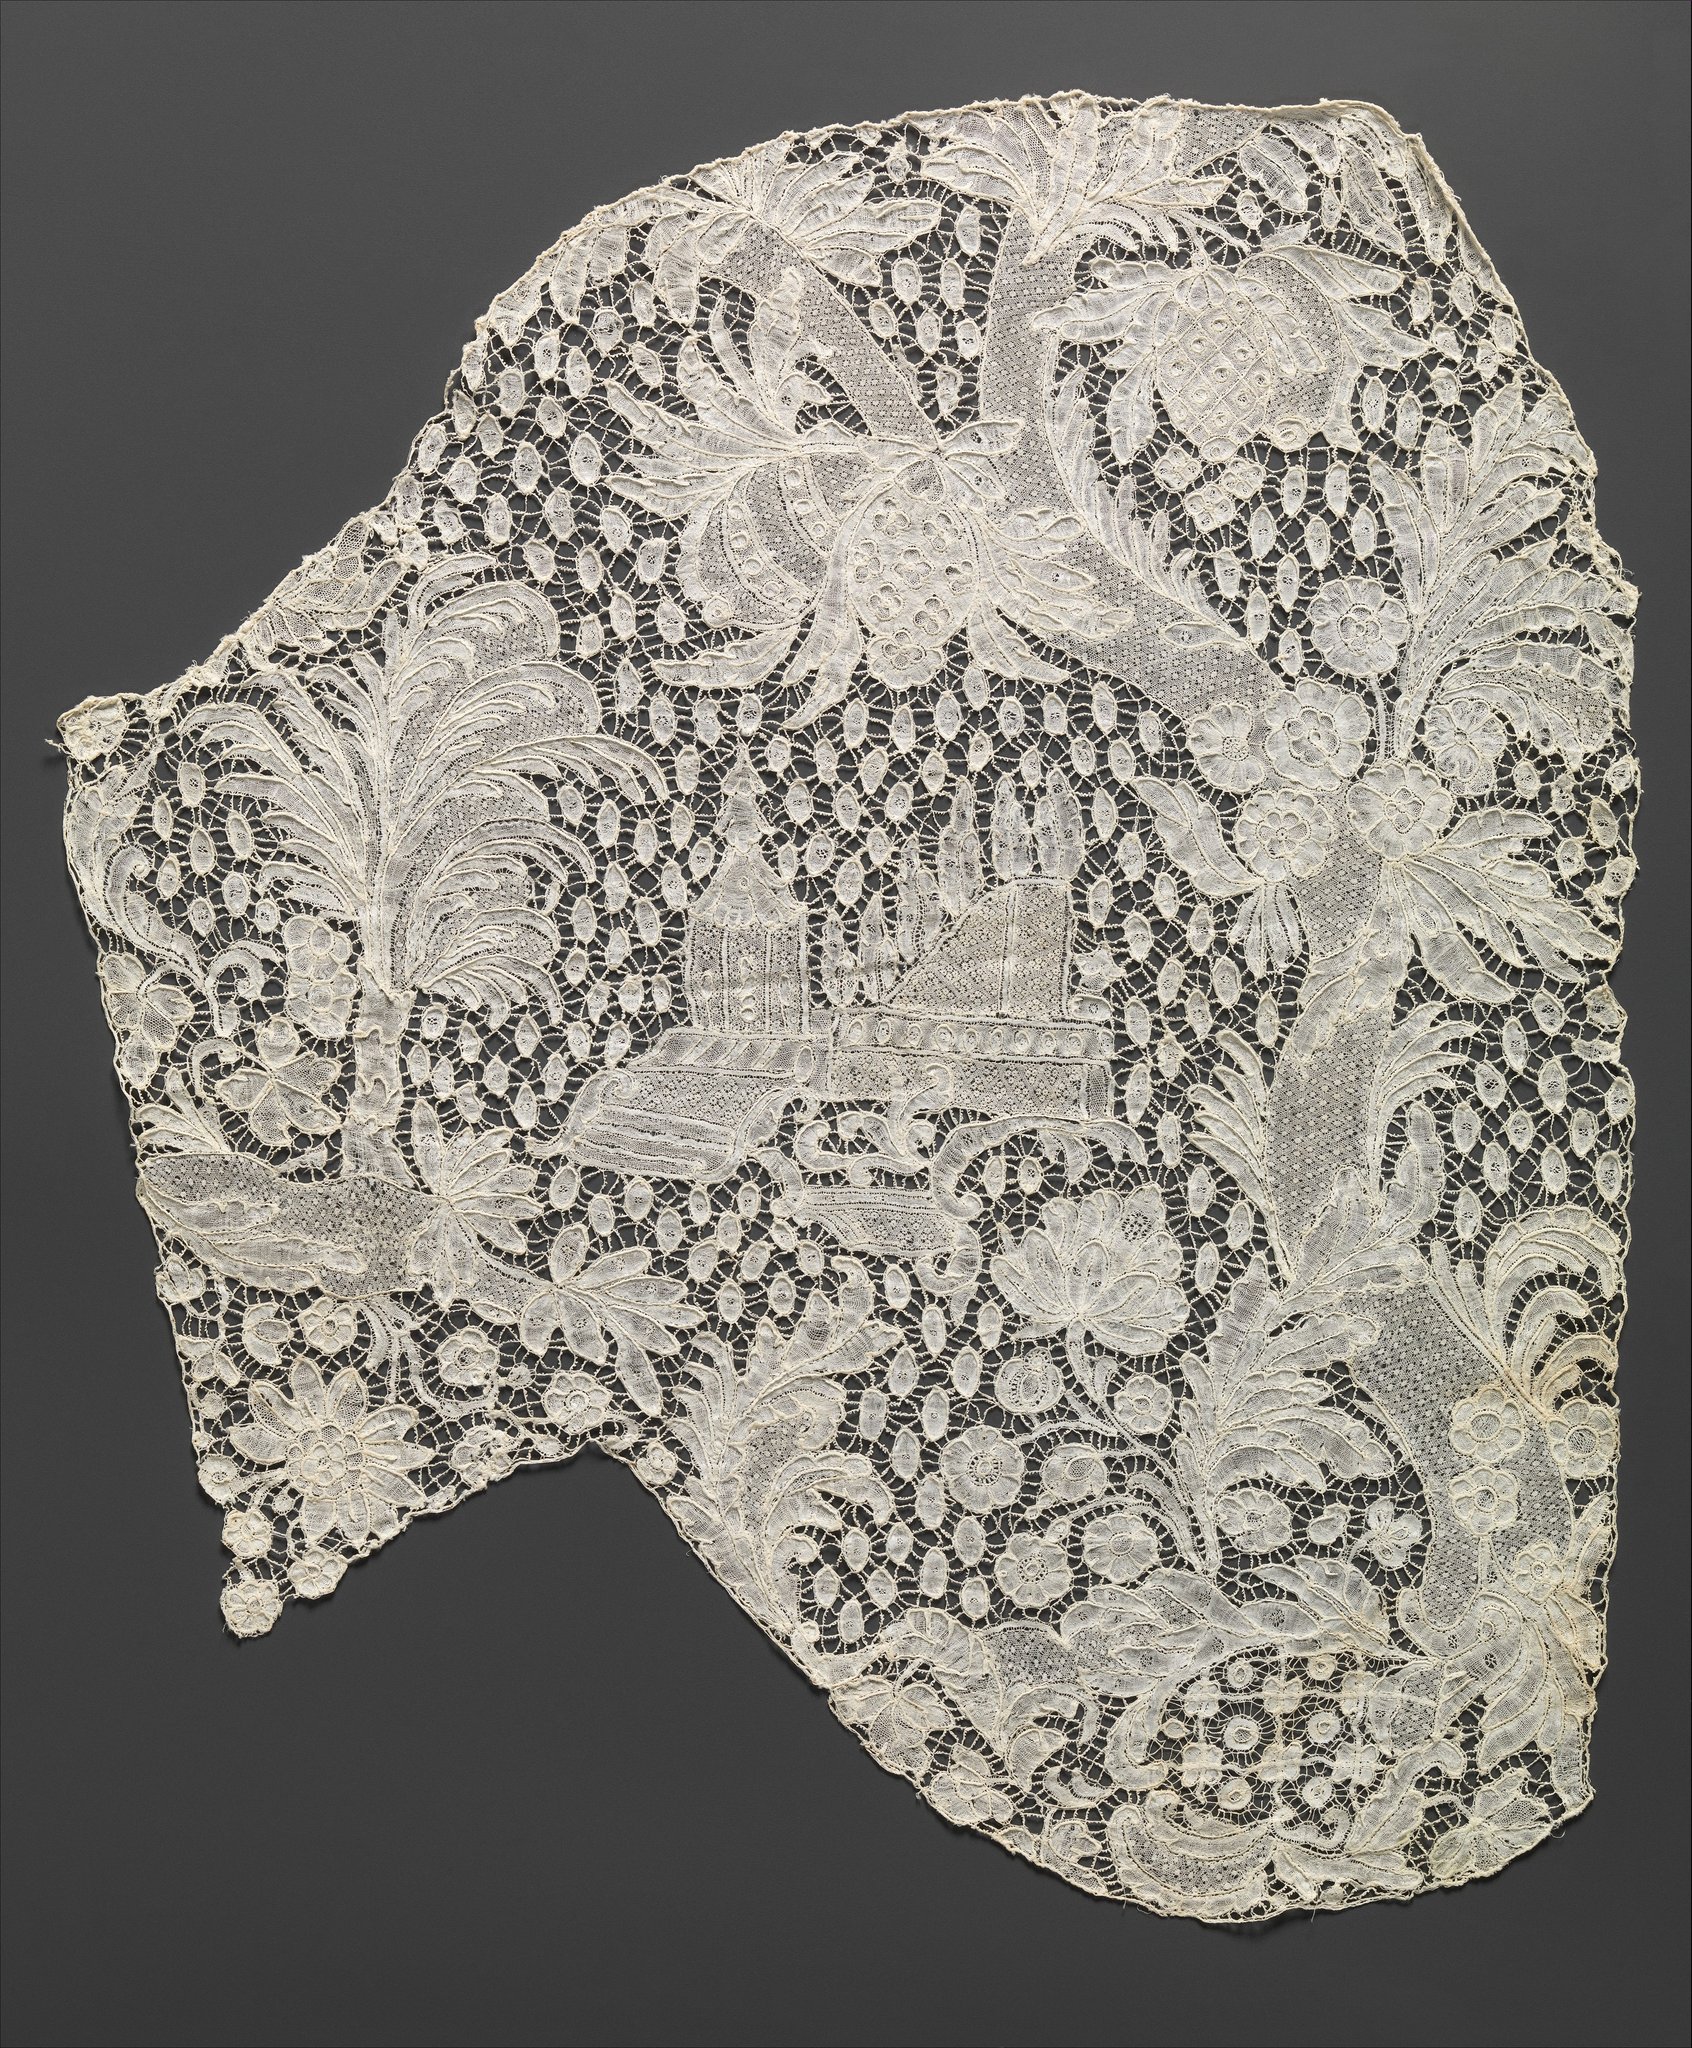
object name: fragment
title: Sleeve fragment of bobbin lace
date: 1740-1750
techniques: lace